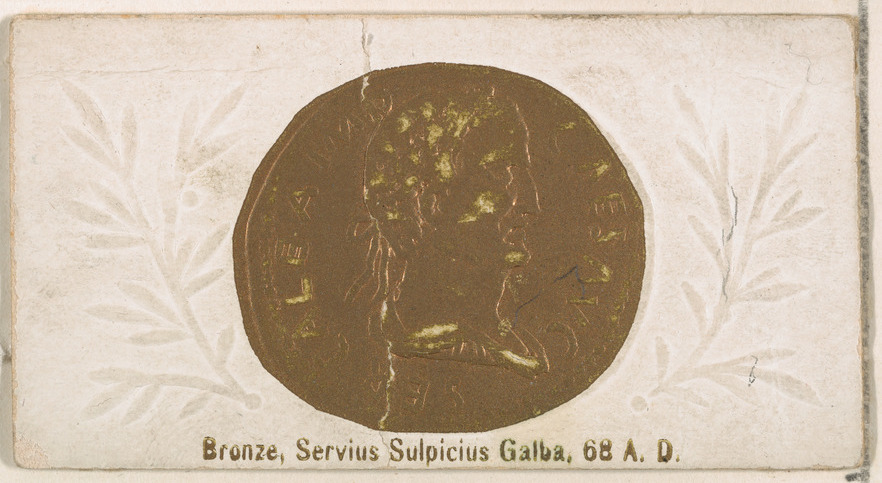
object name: print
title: Bronze, Servius Sulpicius Galba, 68 A.D., from the Ancient Coins series (N180) issued by Wm. S. Kimball & Co.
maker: william s. kimball & company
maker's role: publisher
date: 1888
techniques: color lithograph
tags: men,coins